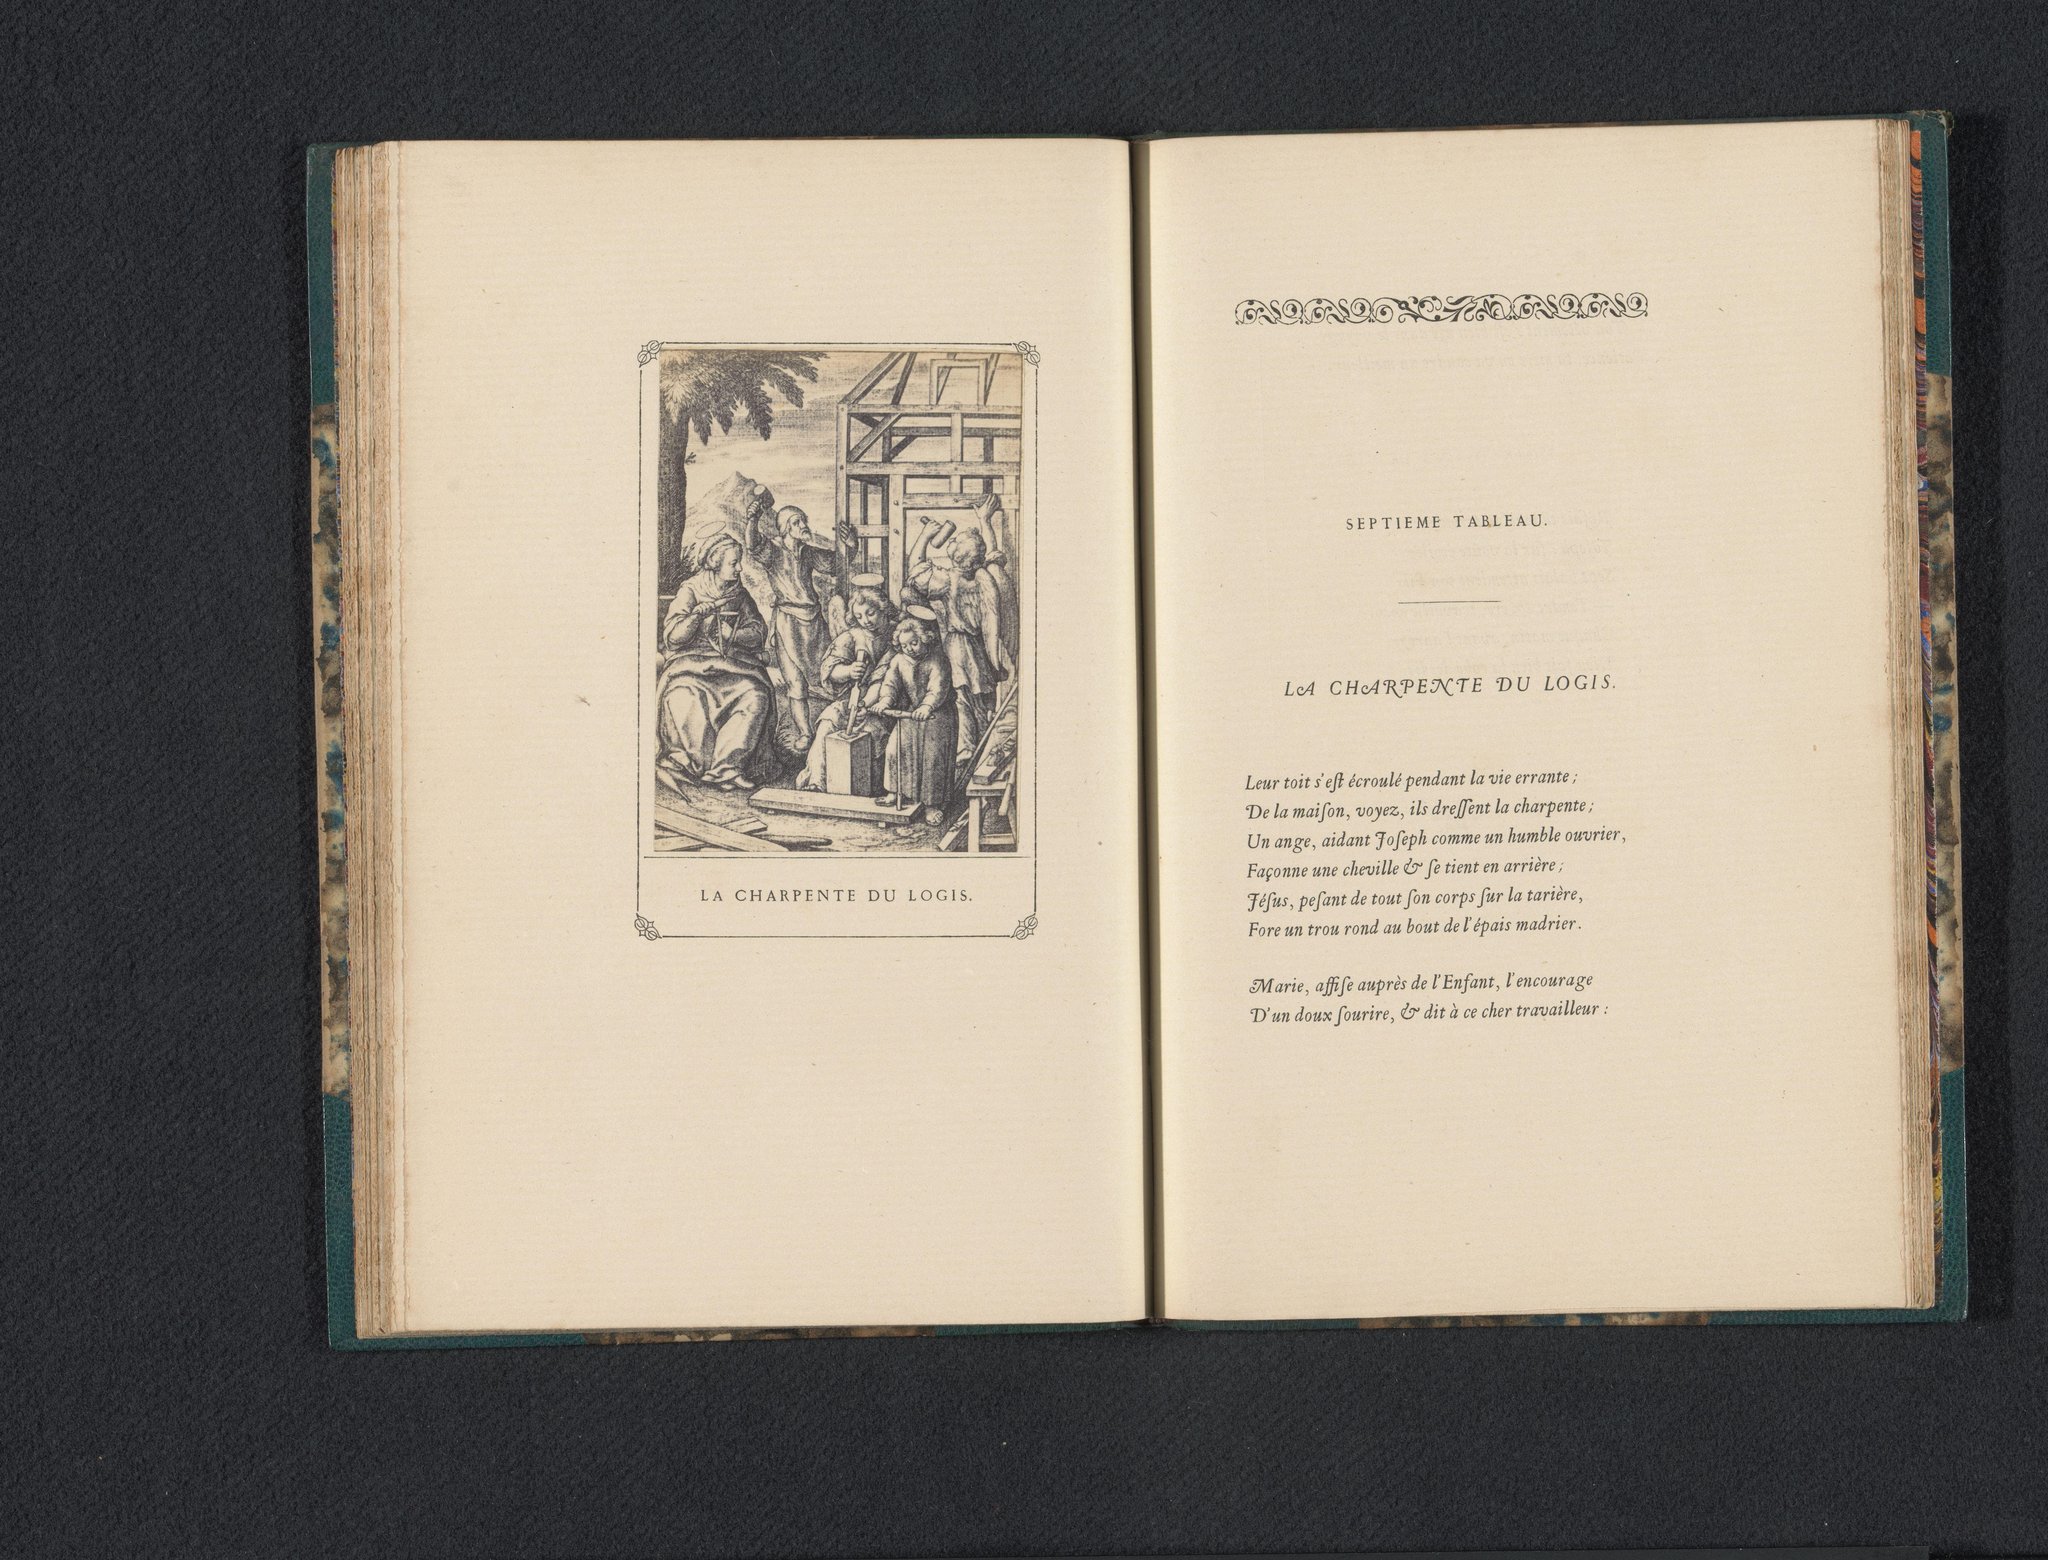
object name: reproduction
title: Fotoreproductie van Le charpente du logis door Edmond Fierlants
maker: edmond fierlants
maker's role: fotograaf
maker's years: 1819-1869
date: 1855-1860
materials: photographic support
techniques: albumen print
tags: carpenter, angels